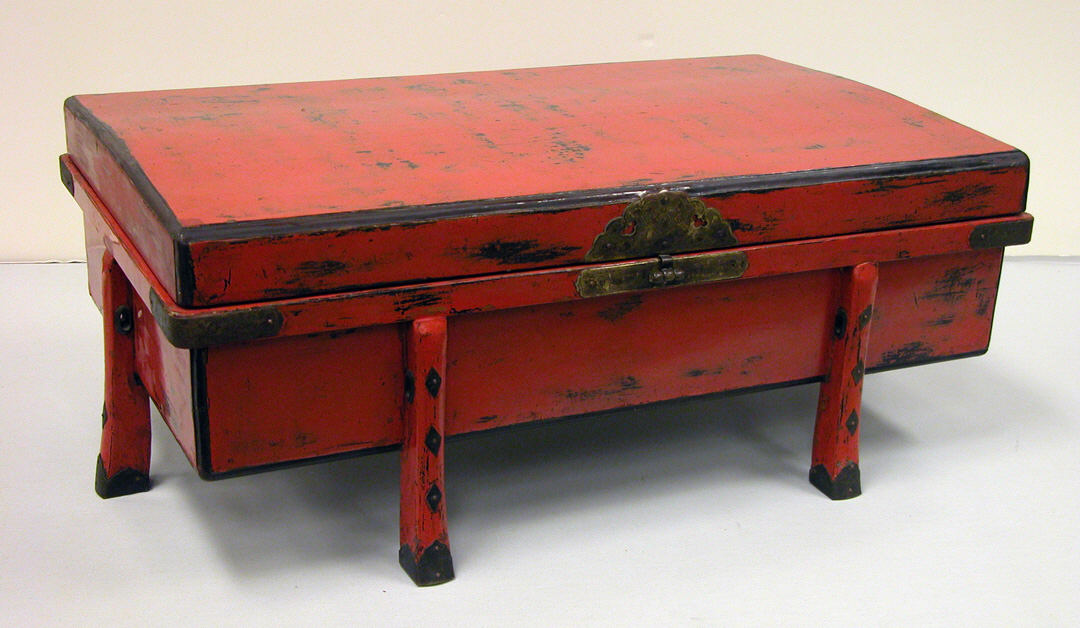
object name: clothing box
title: Garment box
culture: japanese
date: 1615-1868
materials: bronze, lacquer